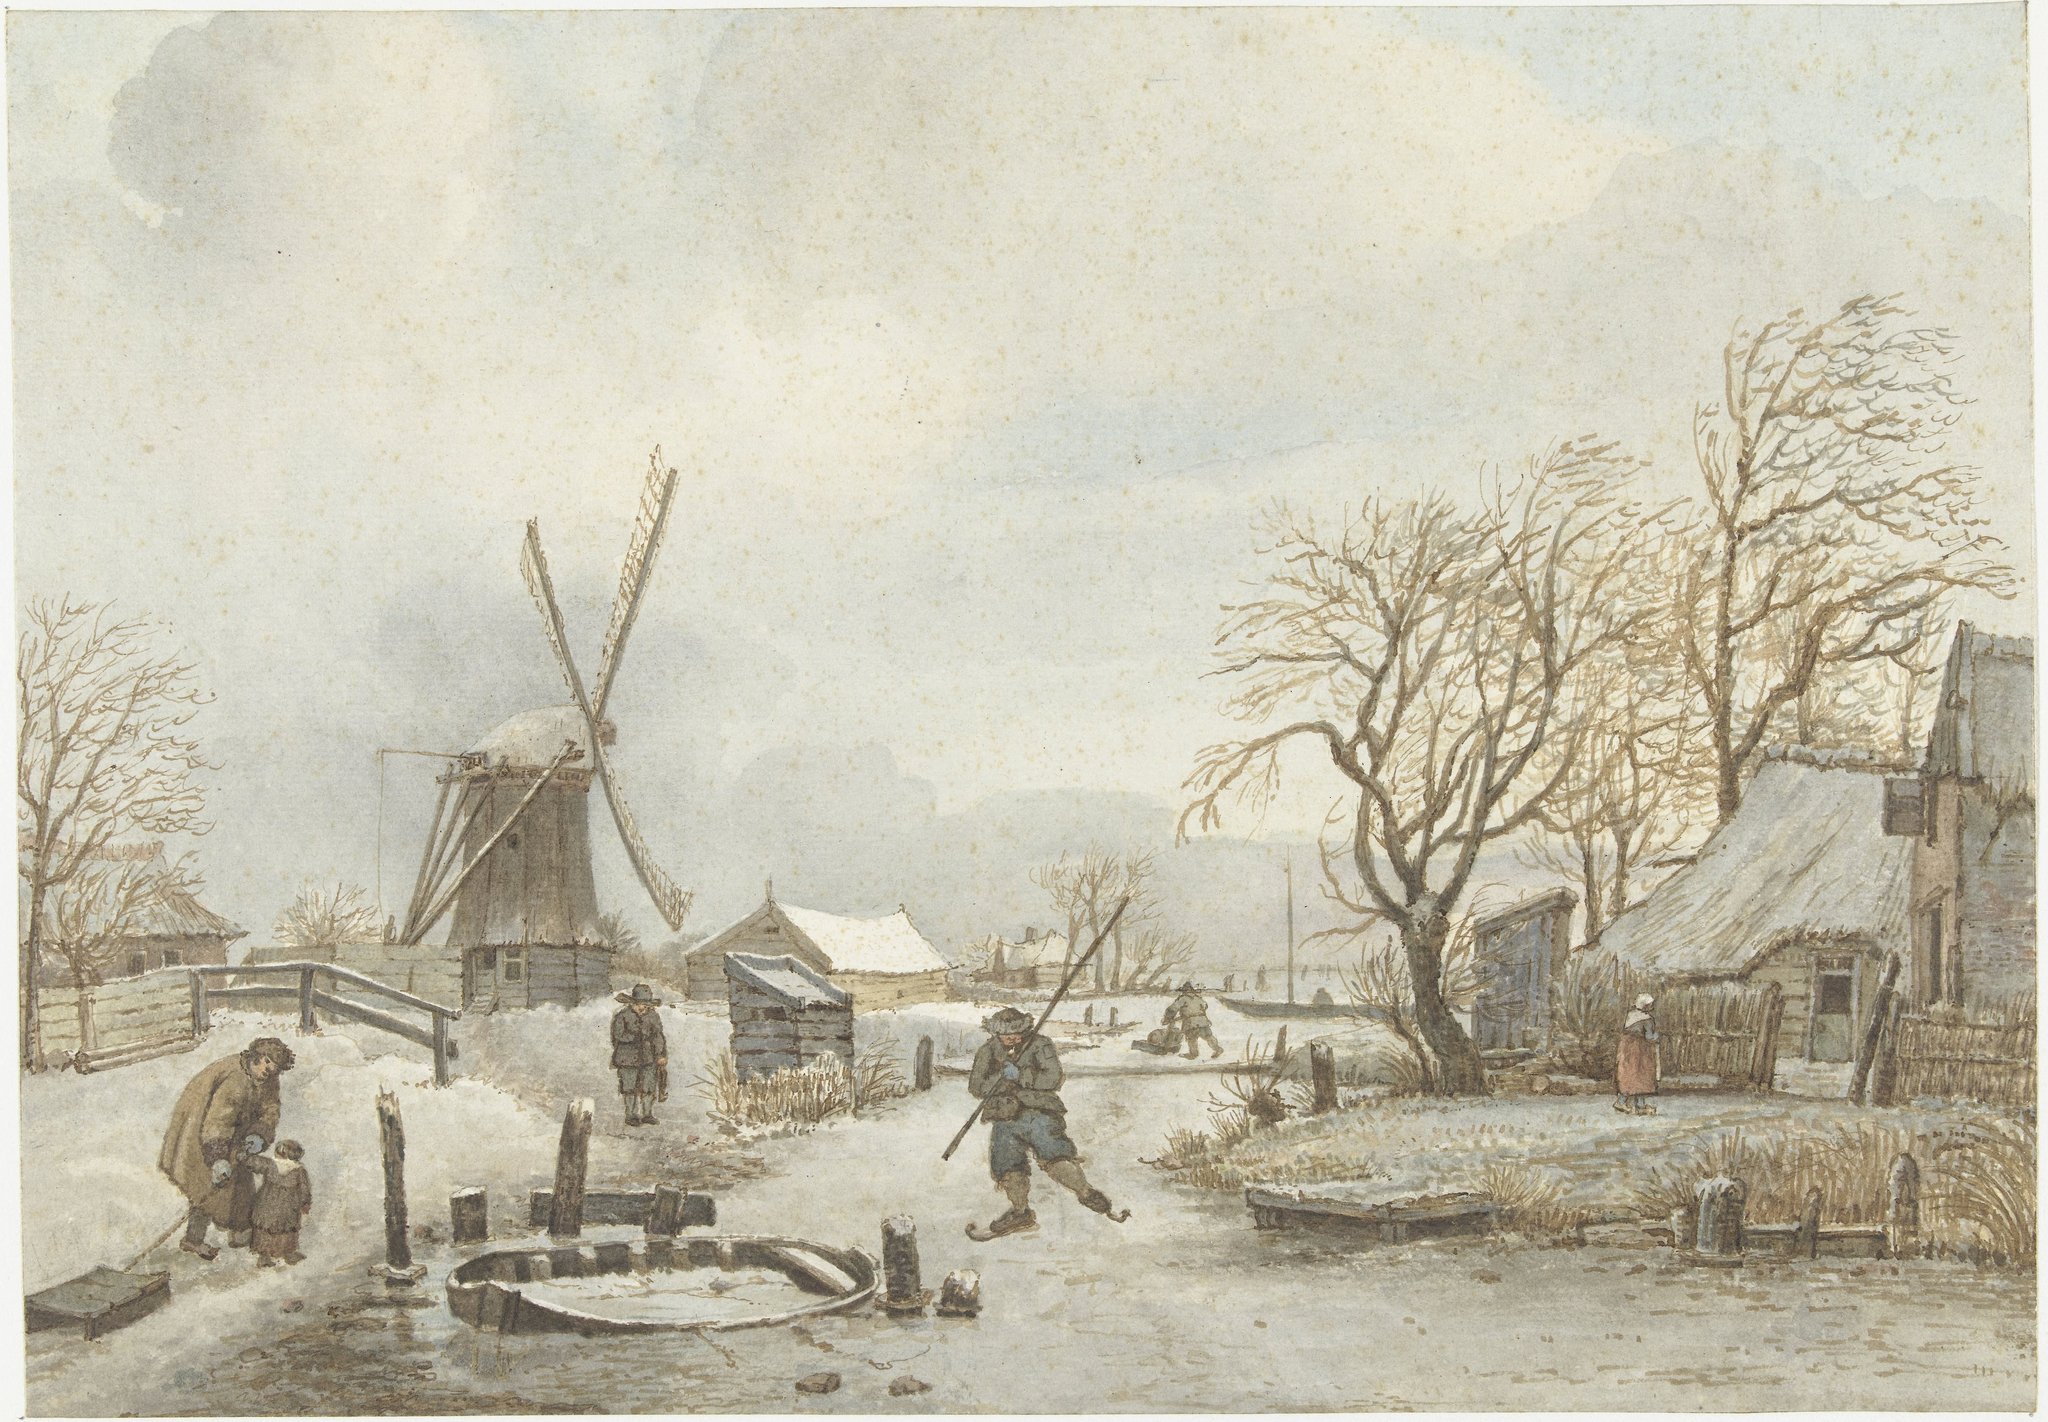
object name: watercolor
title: Winterlandschap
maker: gerrit lamberts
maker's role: bookseller, draughtsman, print maker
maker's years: 1776-1850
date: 1815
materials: ink, paper, watercolor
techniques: brush, pen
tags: winter sports, ice ~ freezing weather